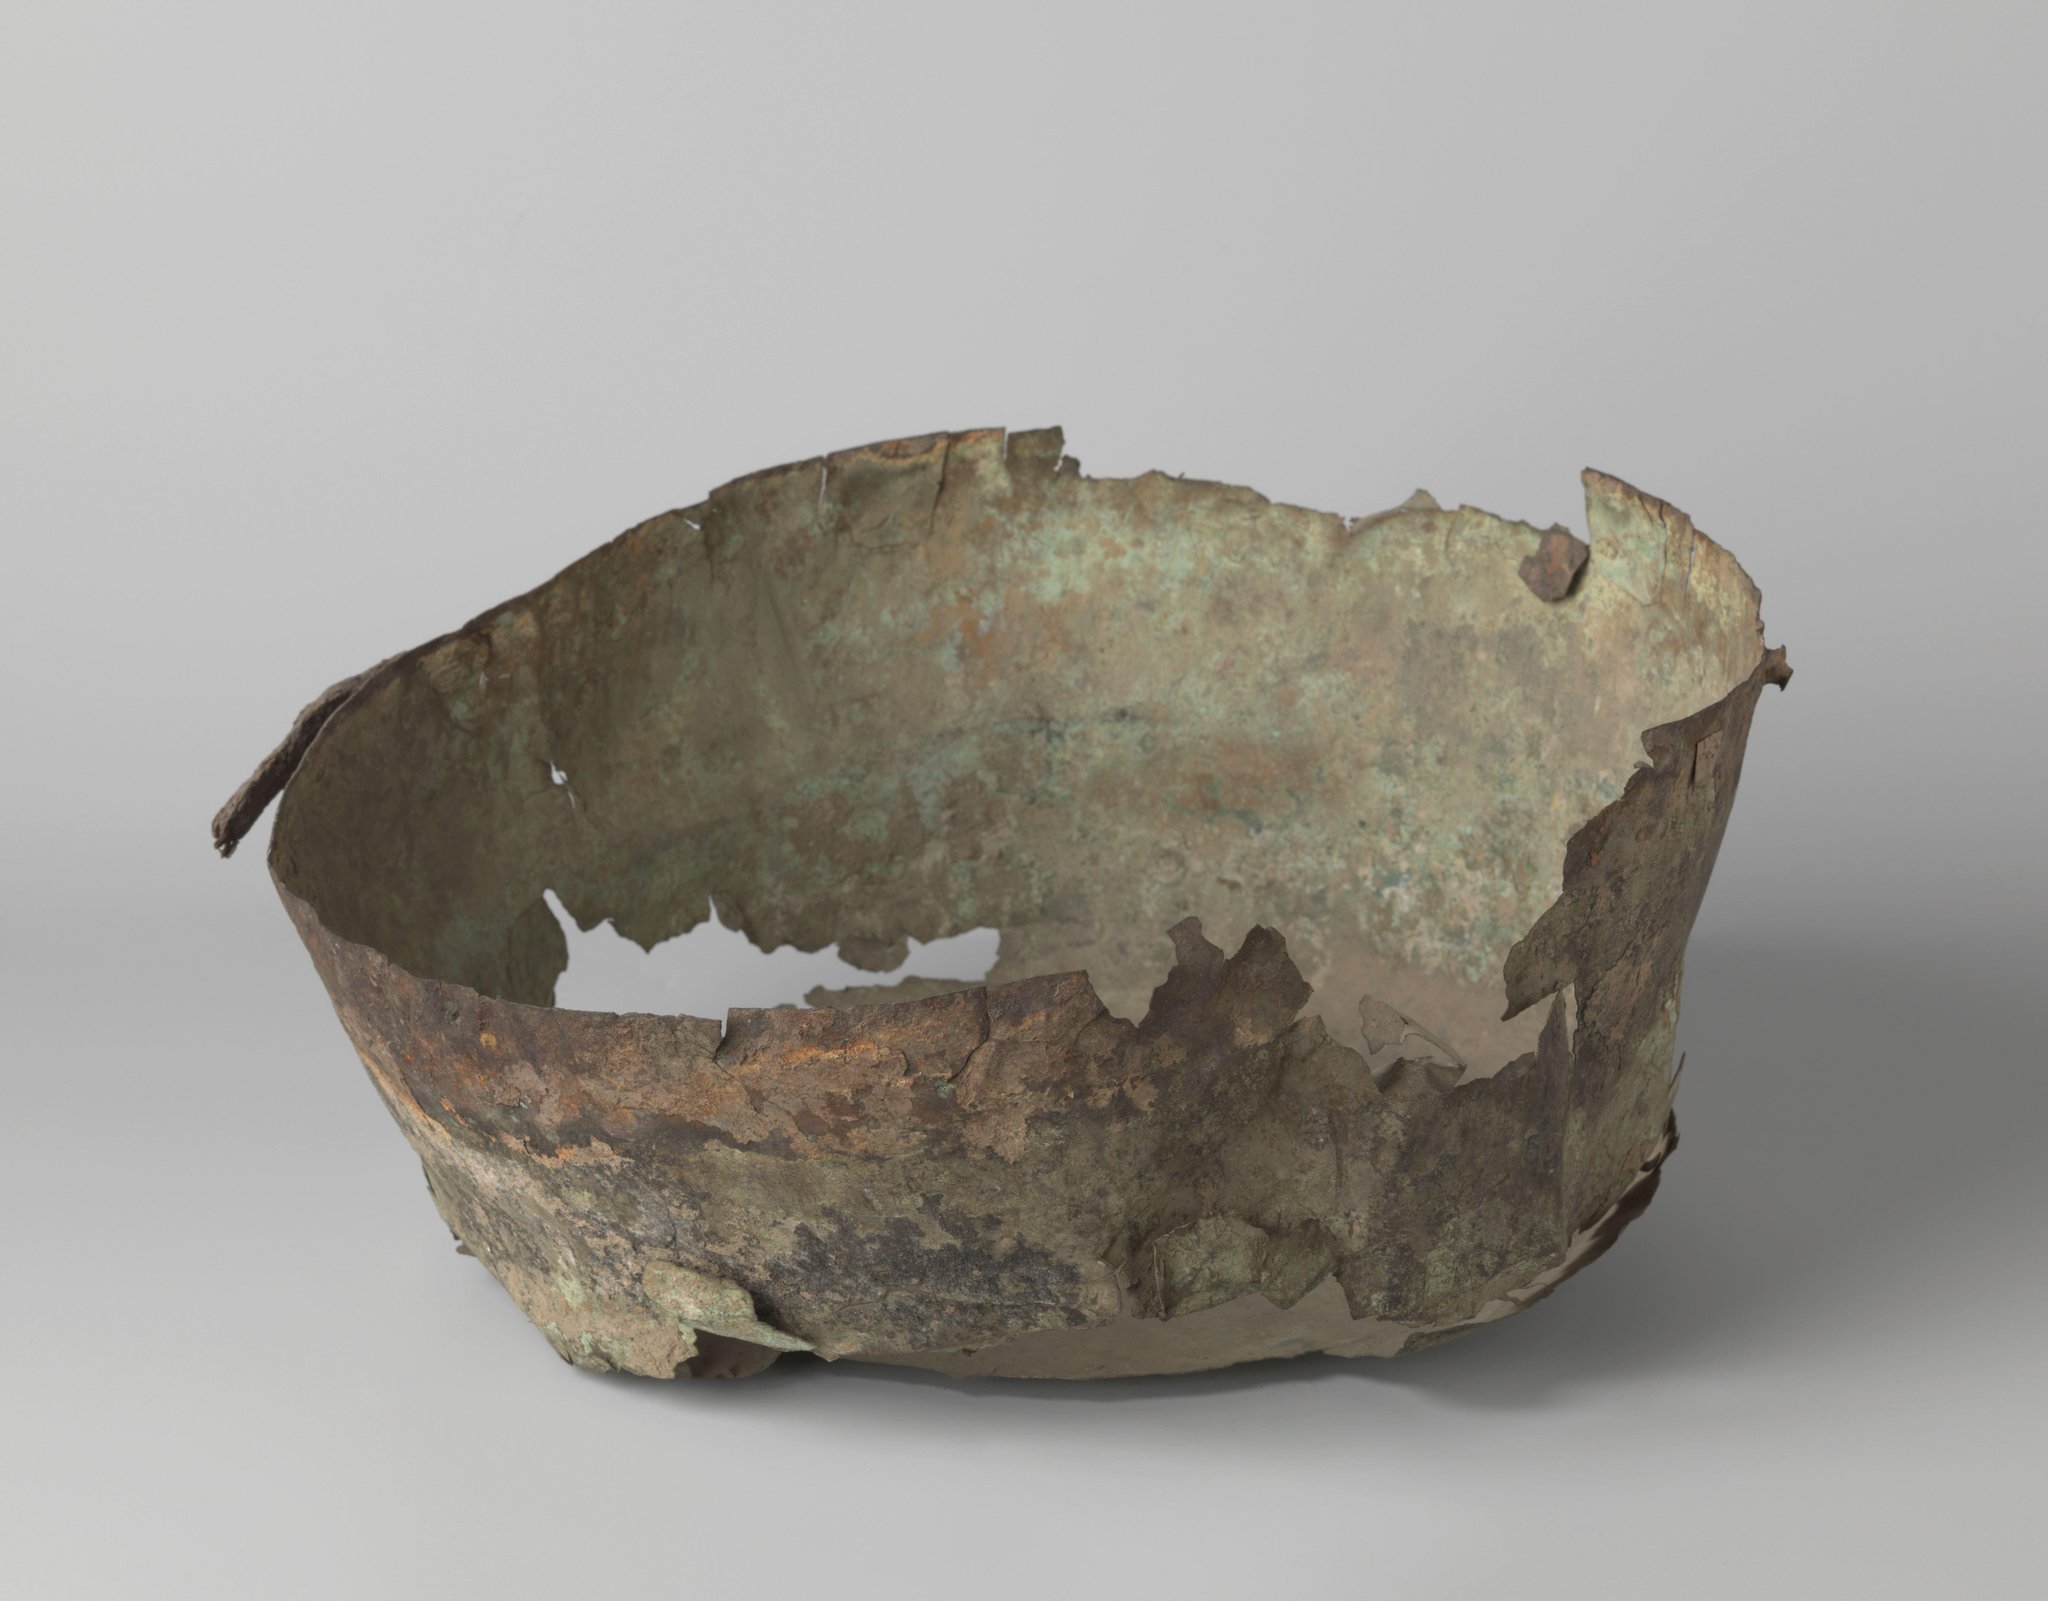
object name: boiler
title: Kookketel van koper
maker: Anonymous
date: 1550-1650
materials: copper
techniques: riveted, striking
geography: low countries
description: Ronde kookketel van koper. De ketel liep van onderen rond. Enkele ingezette stukken, die als reparatie dienen, zijn vastgeklonken. Aan de rand bevindt zich nog een deel van het hengsel.